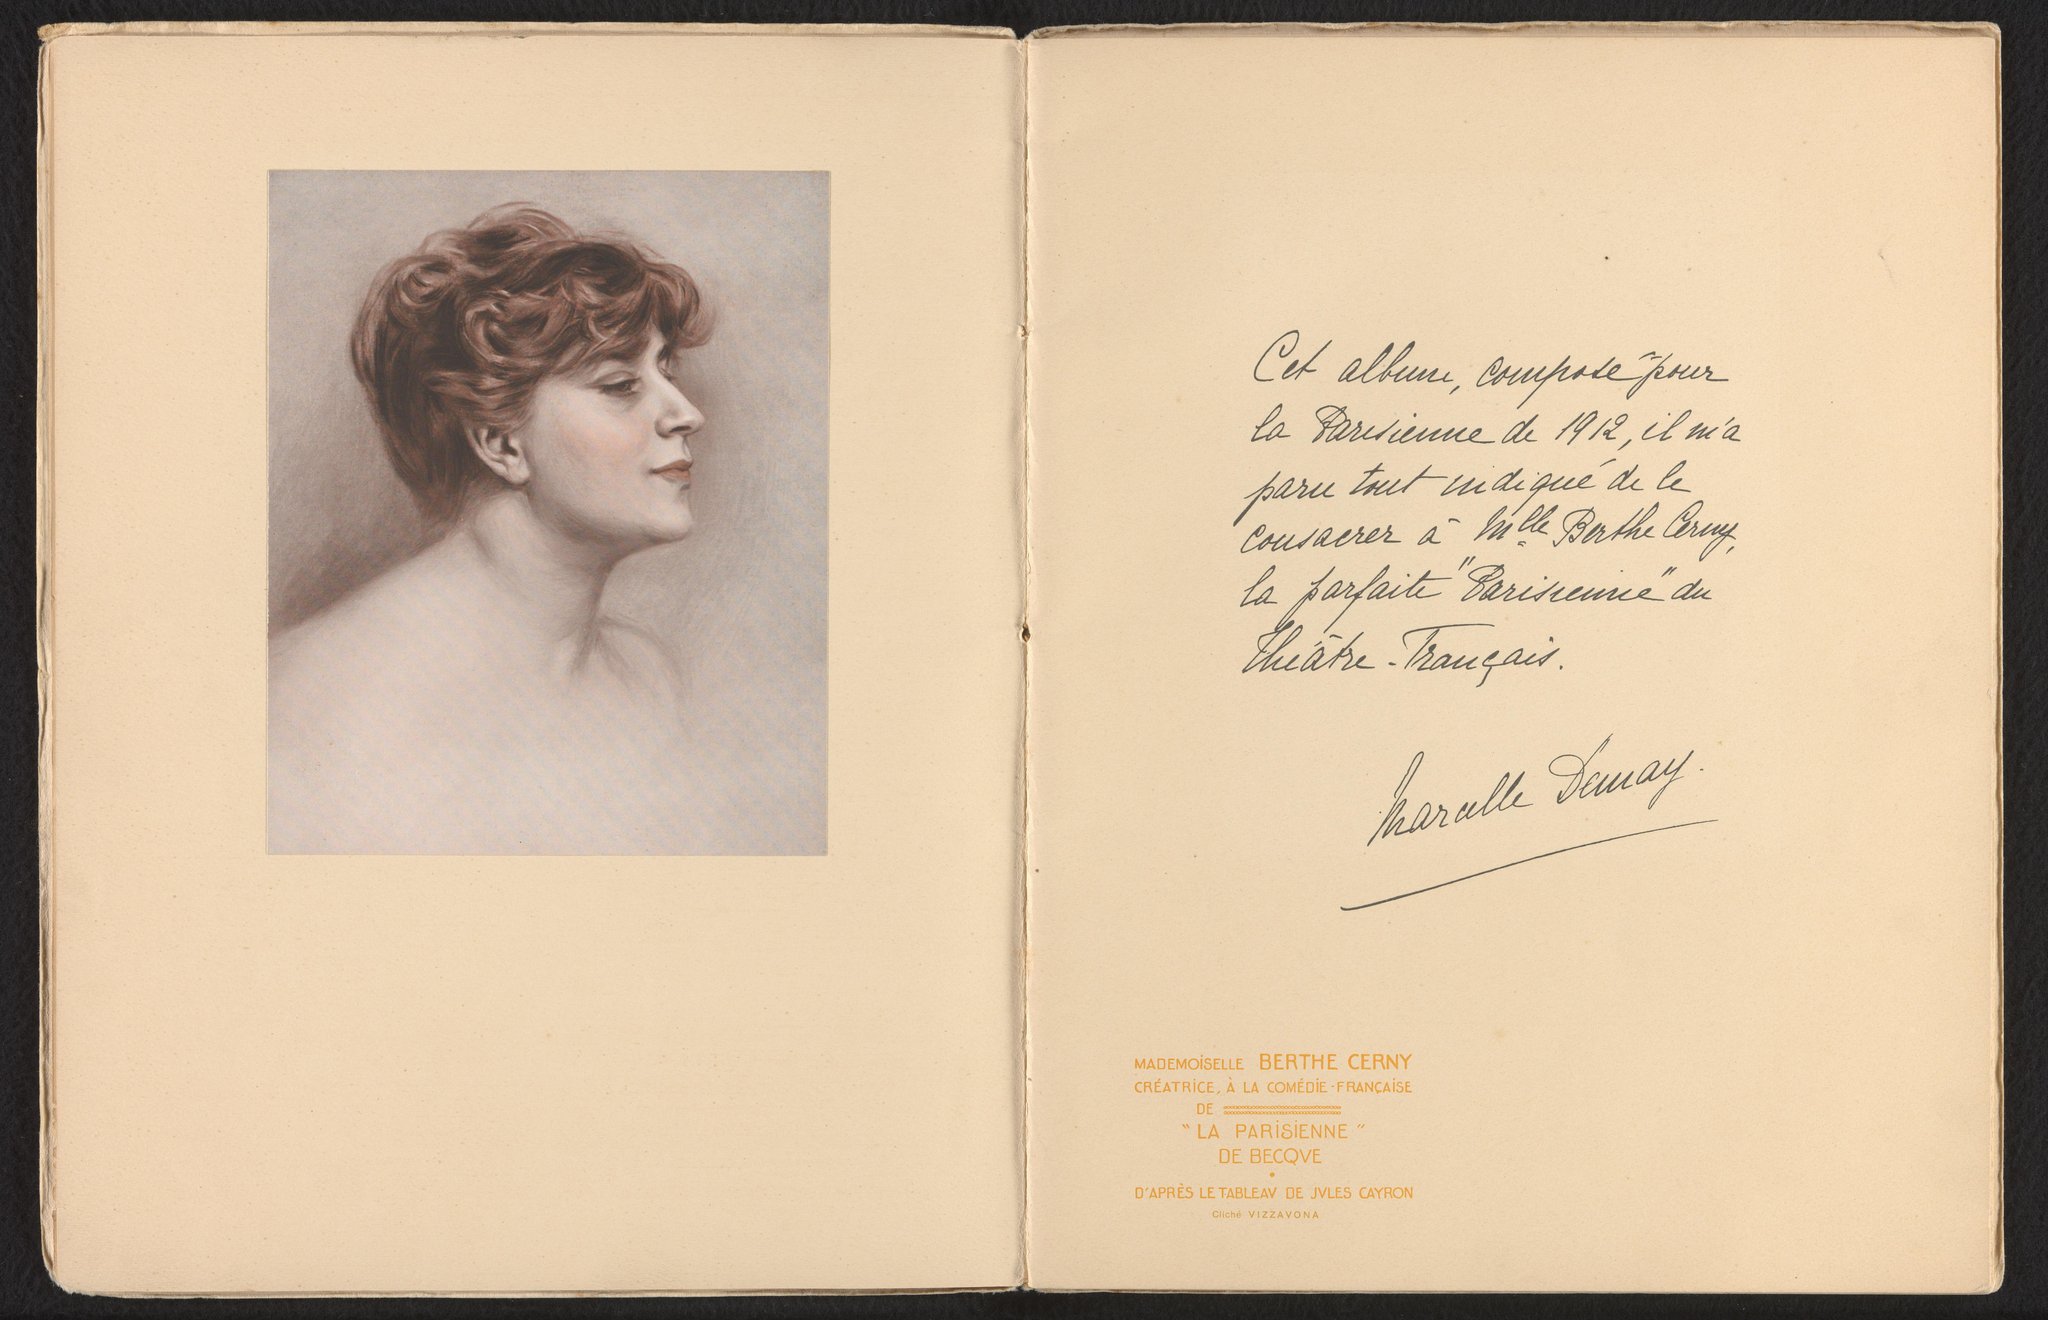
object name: photomechanical print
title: Medemoiselle Berthe Cerny créatrice, à la comédie francaise la parisienne de Becque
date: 1907-1912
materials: paper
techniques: two-color autotype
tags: paris, historical persons - bb - woman